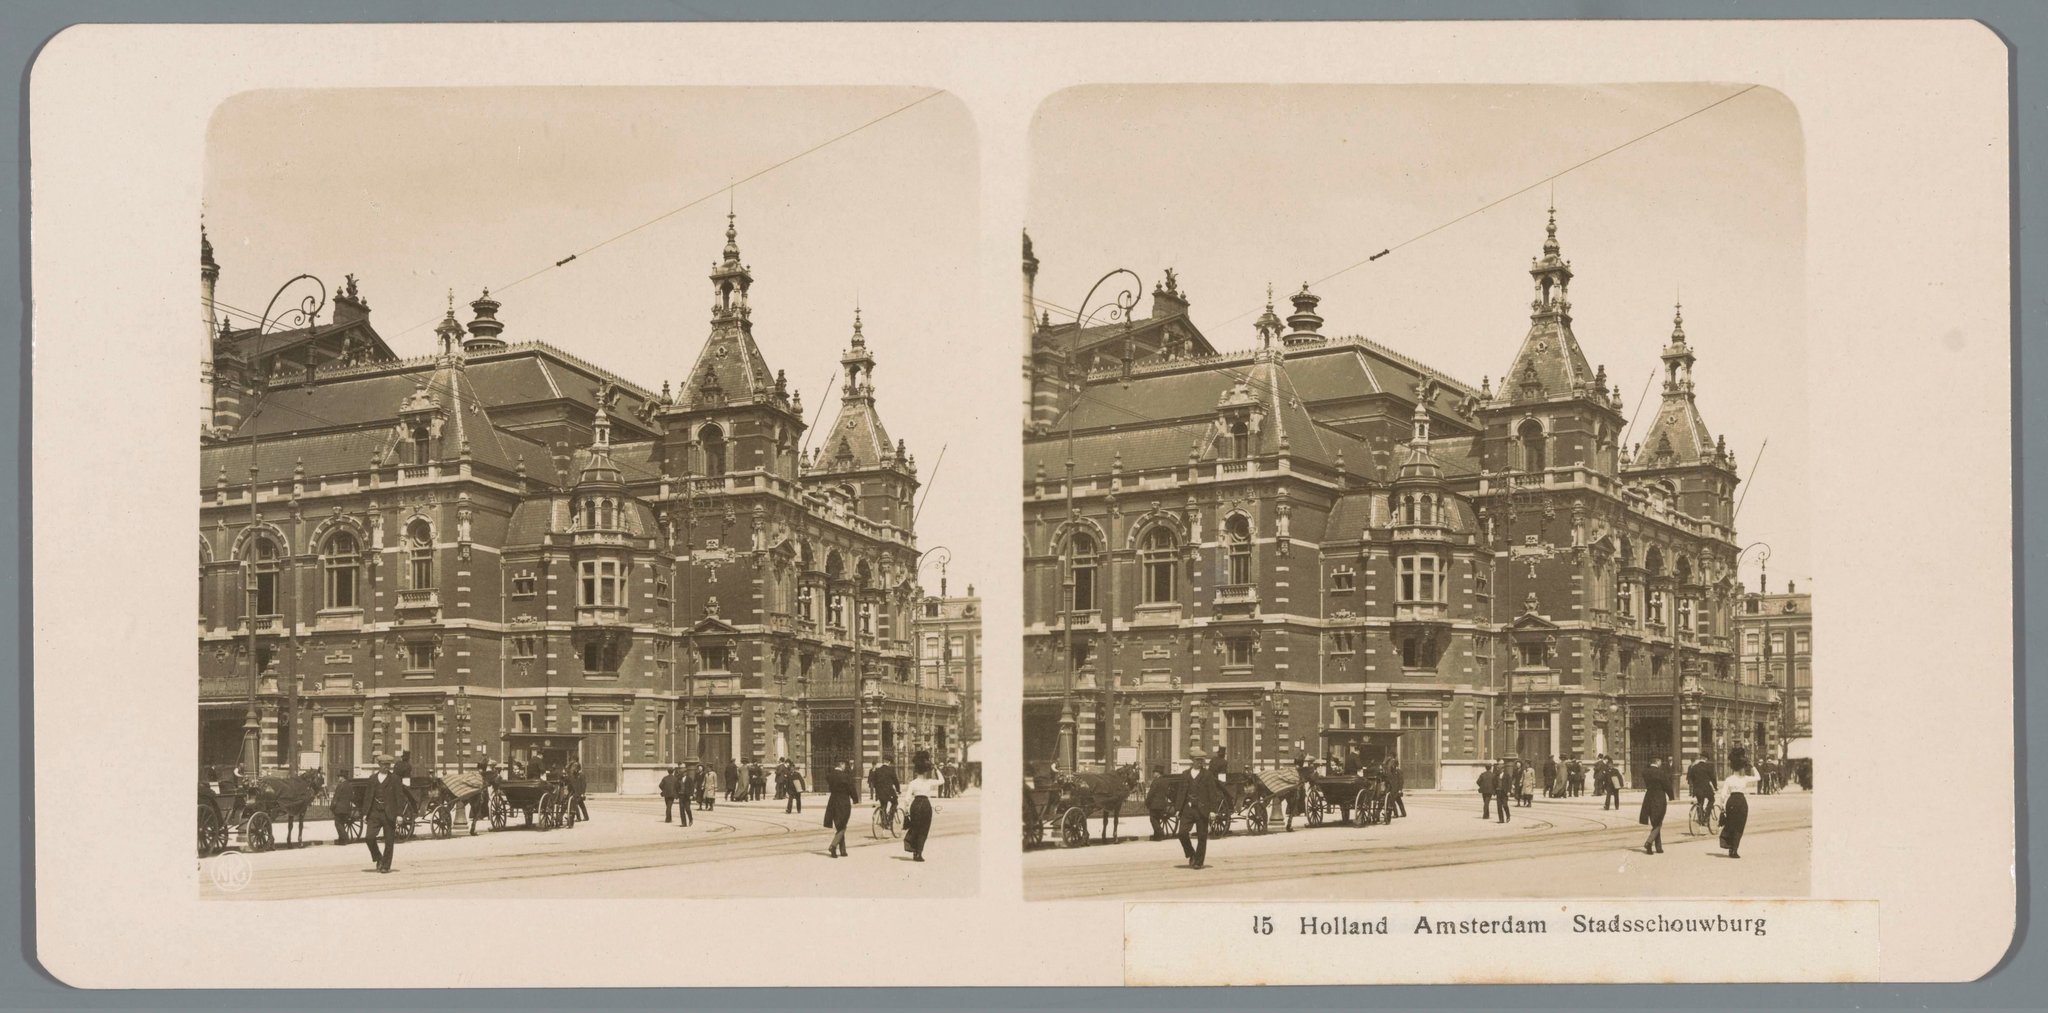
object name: stereograph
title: Exterieur van de Stadsschouwburg te Amsterdam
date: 1900-1910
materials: cardboard, photographic support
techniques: gelatin silver print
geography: amsterdam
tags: theatre (building), façade (of house or building)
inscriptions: number: ‘15’, inscription: ‘NPG’